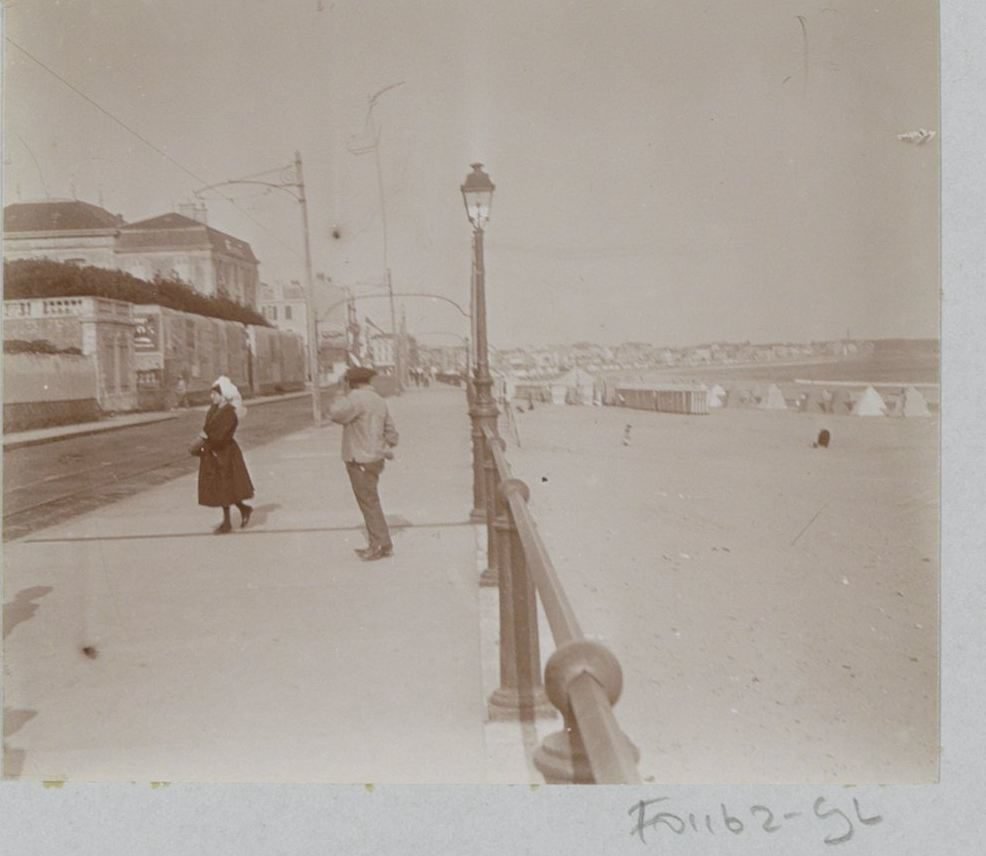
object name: photograph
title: Boulevard langs het strand, vermoedelijk bij La Rochelle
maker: Anonymous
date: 1905-1910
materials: paper, photographic support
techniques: gelatin silver print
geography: la rochelle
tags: avenue, boulevard, promenade, esplanade (+ city(-scape) with figures, staffage), beach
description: Onderdeel van Fotoalbum van een Franse amateurfotograaf met bezienswaardigheden in Frankrijk, Zwitserland en Italië.